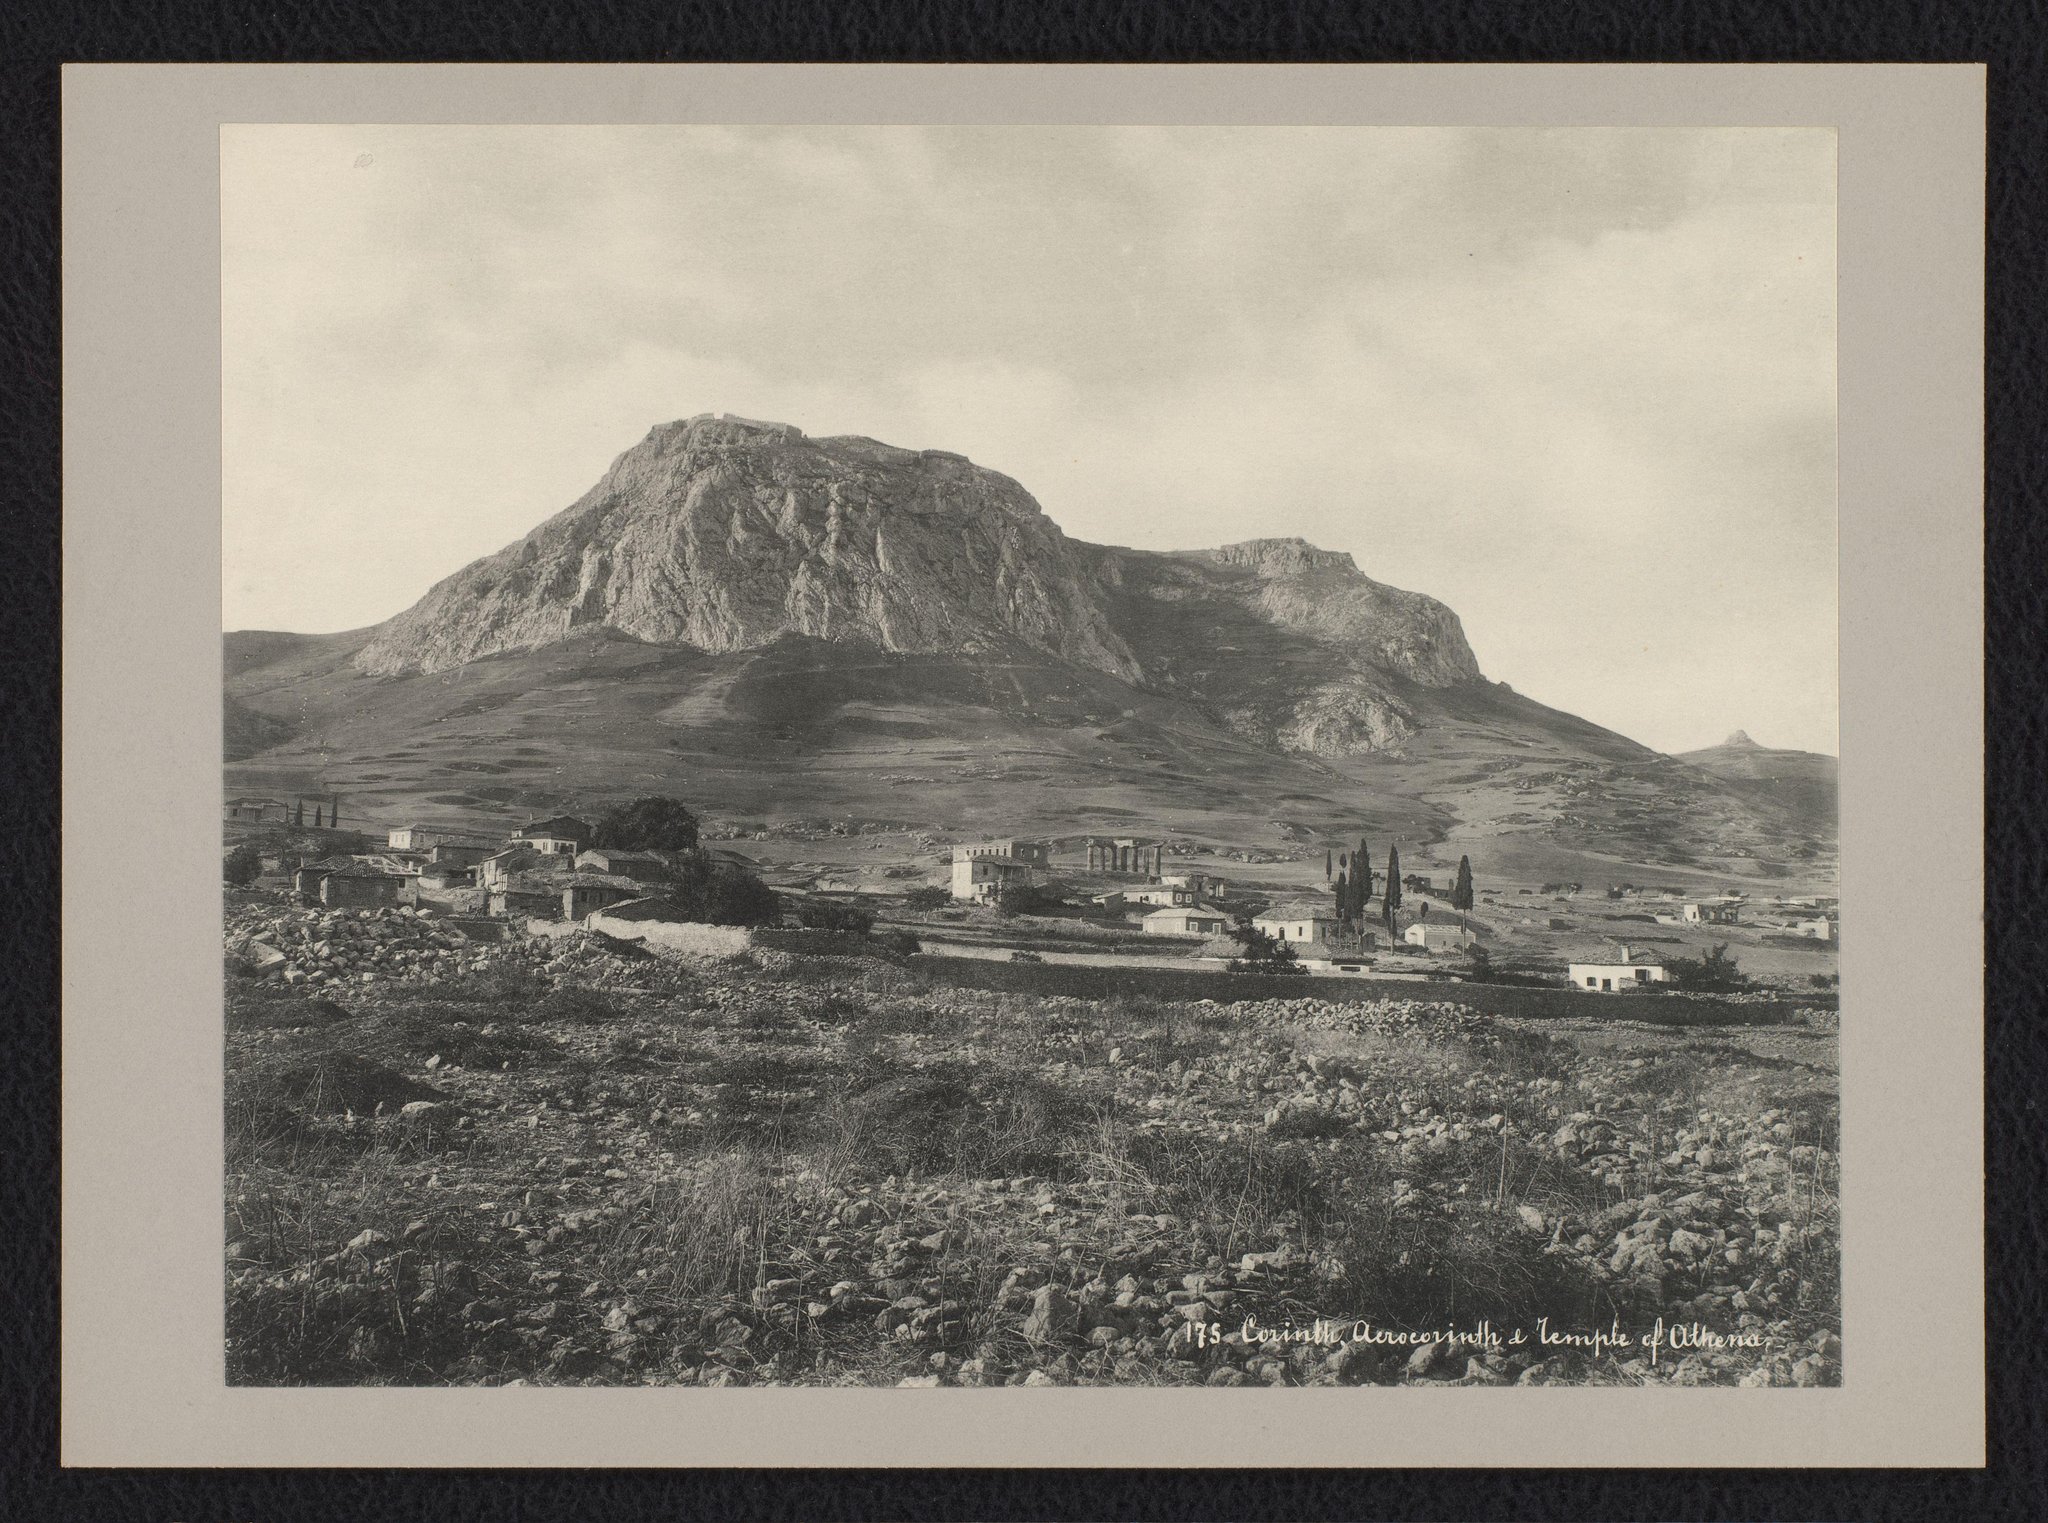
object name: photograph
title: 175 Corinth, Aeroc & Temple of Athena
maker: Anonymous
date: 1895-1915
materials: cardboard, paper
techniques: photograph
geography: greece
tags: griekenland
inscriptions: number: ‘13.’